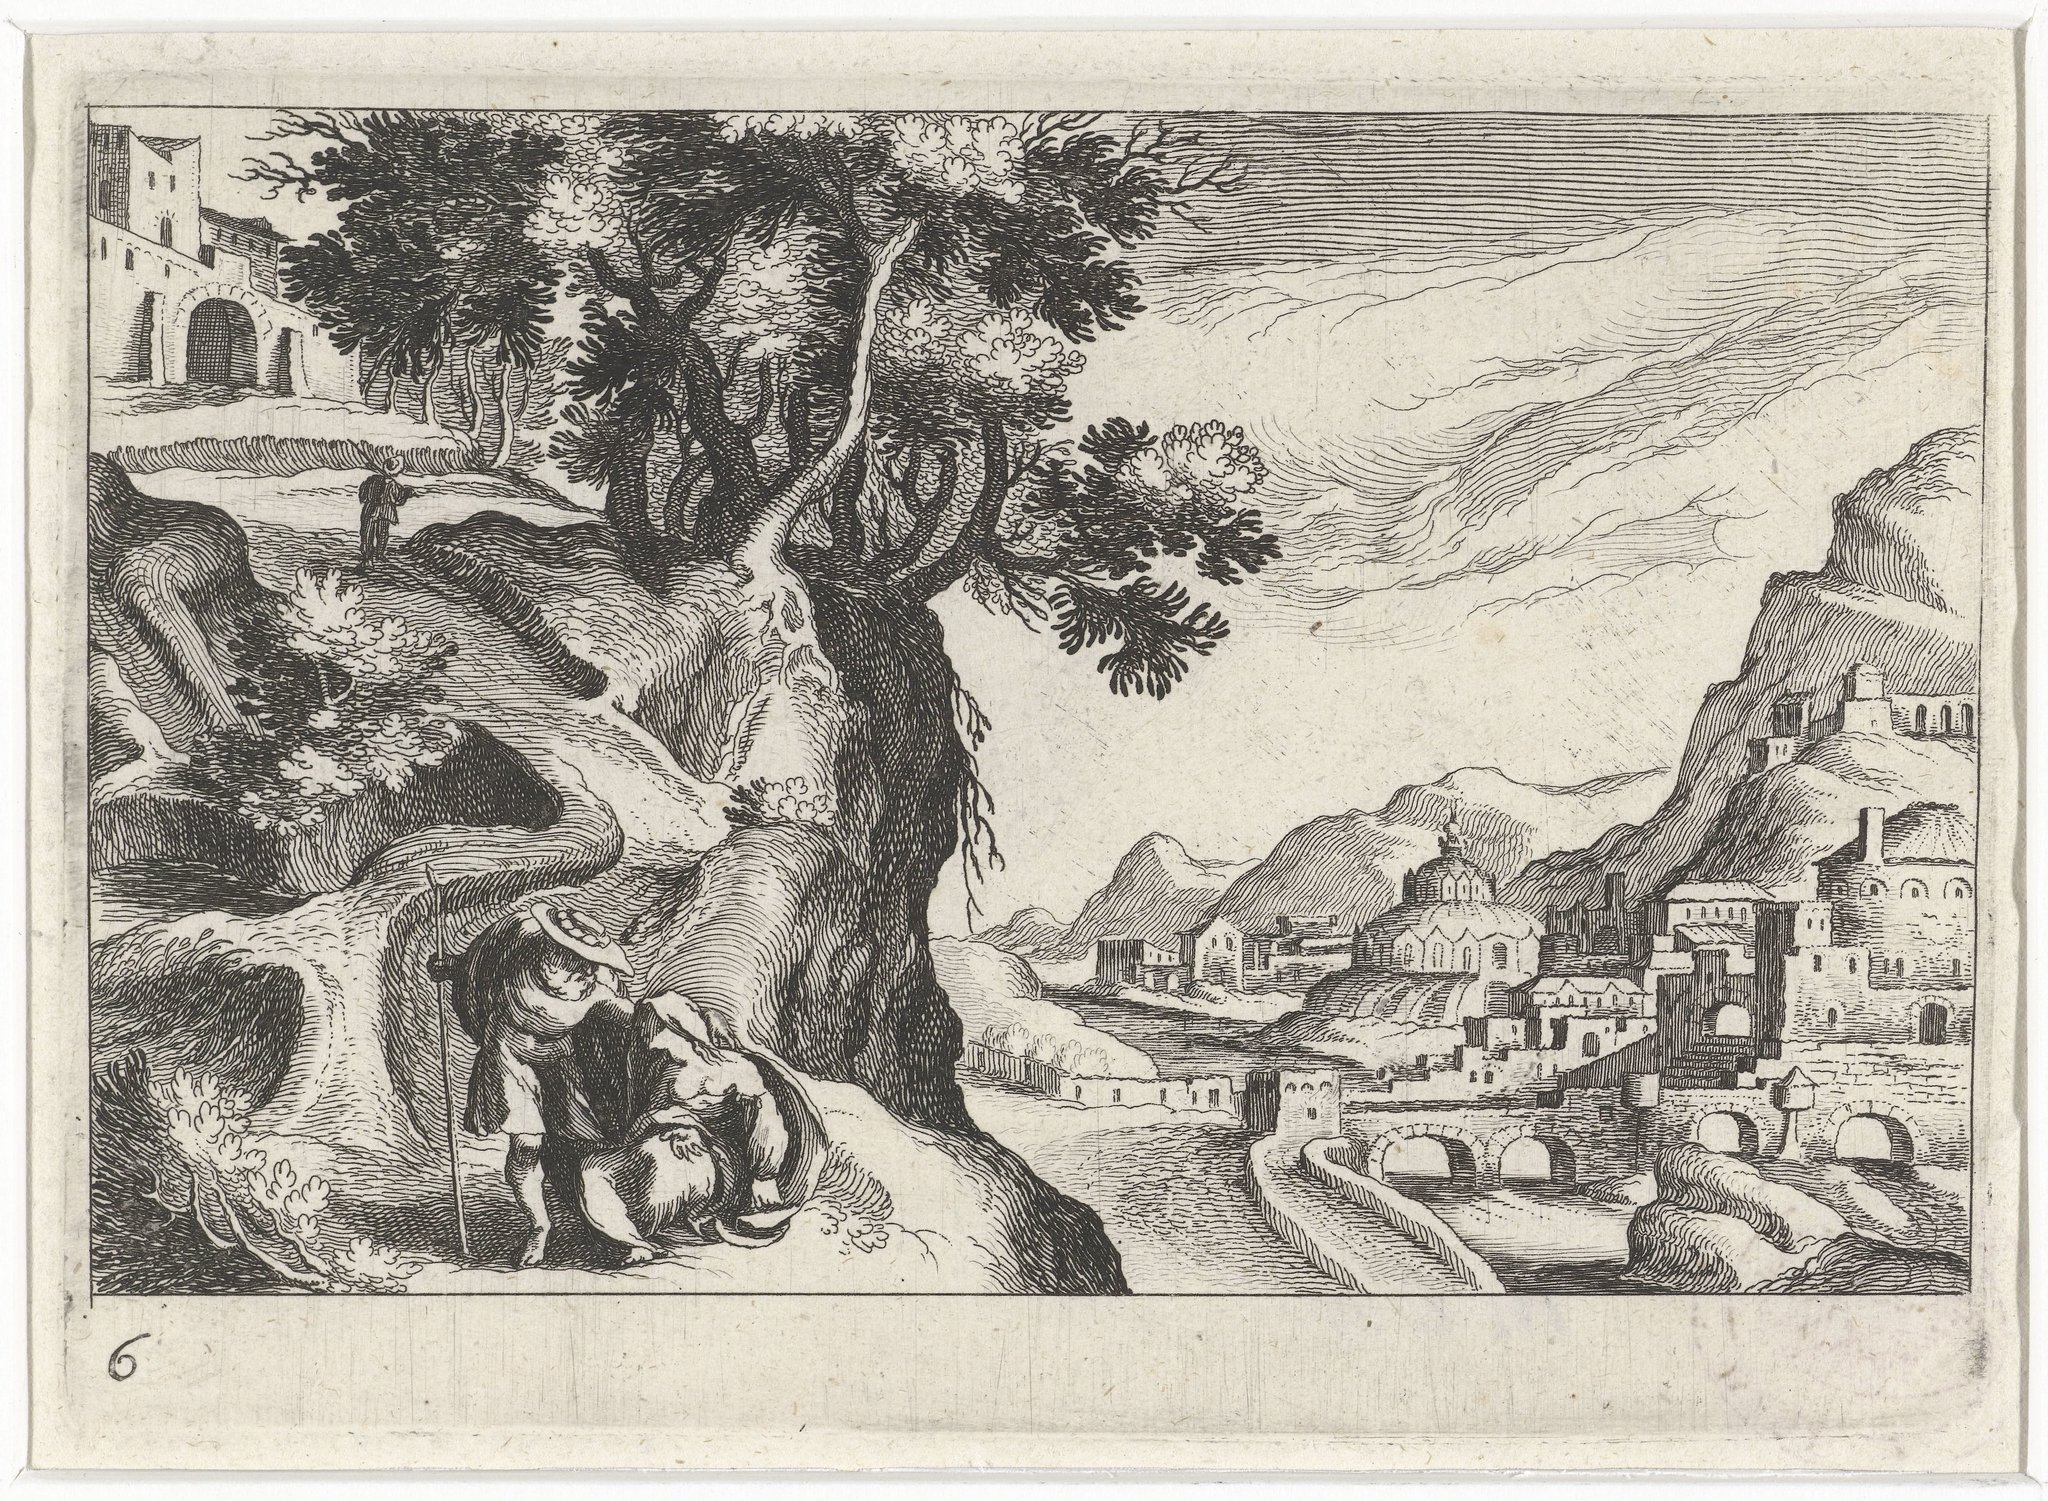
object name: print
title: Zuid-Europese landschappen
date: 1611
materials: paper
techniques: etching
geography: the hague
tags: tamar changes from her widow's clothes and covers her face with a veil after the manner of the prostitutes; sitting at the entrance of a city on the road to timnath she awaits judah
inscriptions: collector's mark: Lugt 240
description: Landschap met Juda en Tamar op de voorgrond. Links een steile heuvel met daarop een gebouw. Rechts een stad aan een rivier.